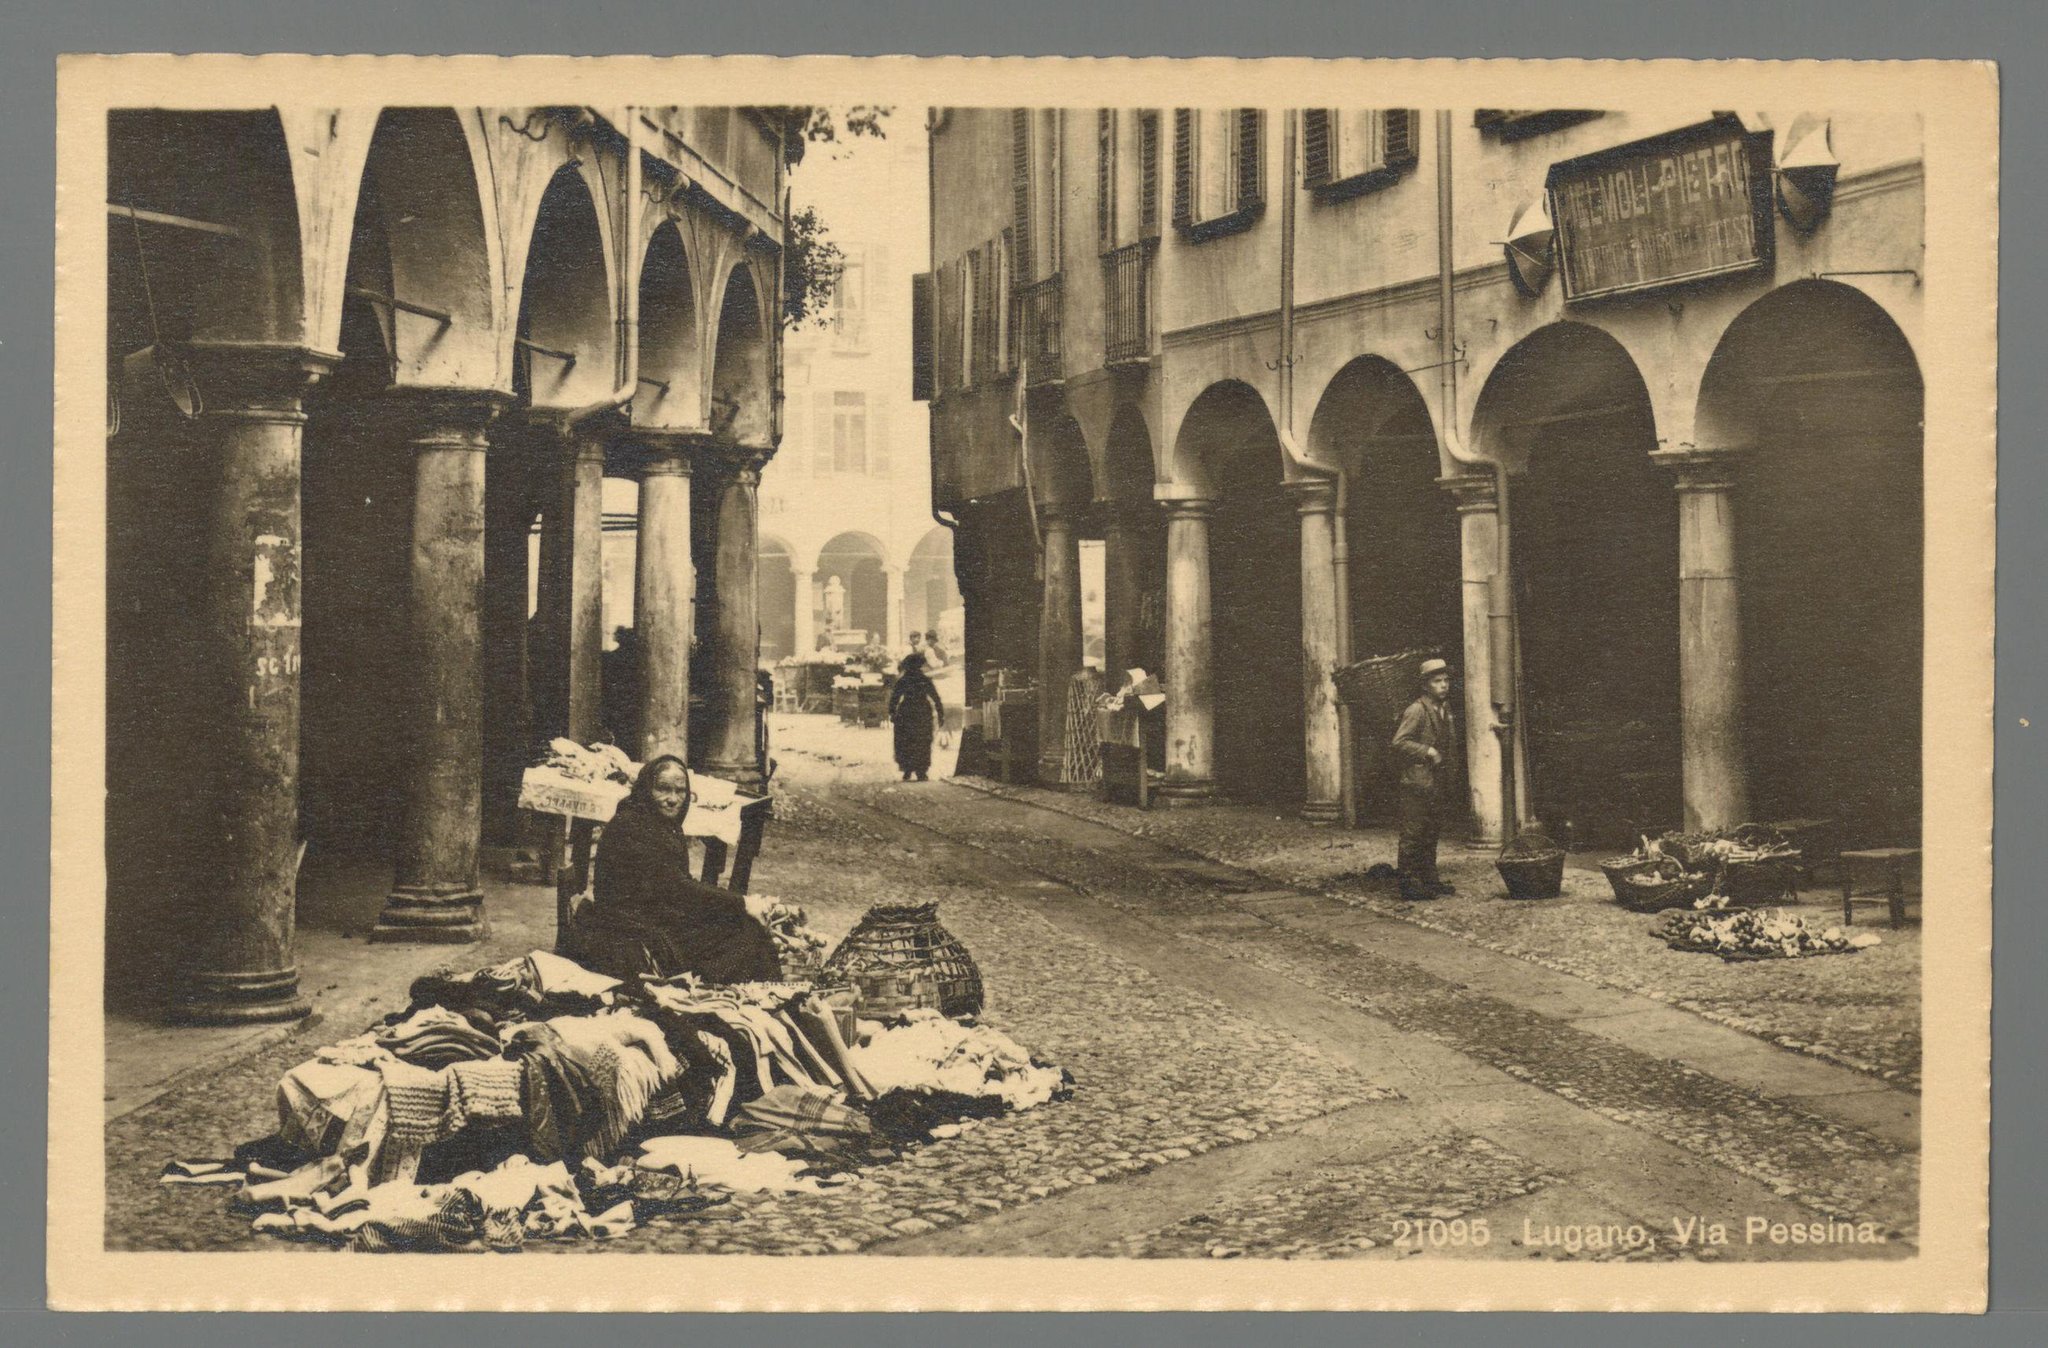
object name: ansichtkaart, prentbriefkaart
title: Lugano. Via Pessina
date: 1905-1924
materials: photographic support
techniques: photography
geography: kilchberg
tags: wandering or travelling merchant - bb - women engaged in trade and commerce, city-view, and landscape with man-made constructions (+ city(-scape) with figures, staffage)